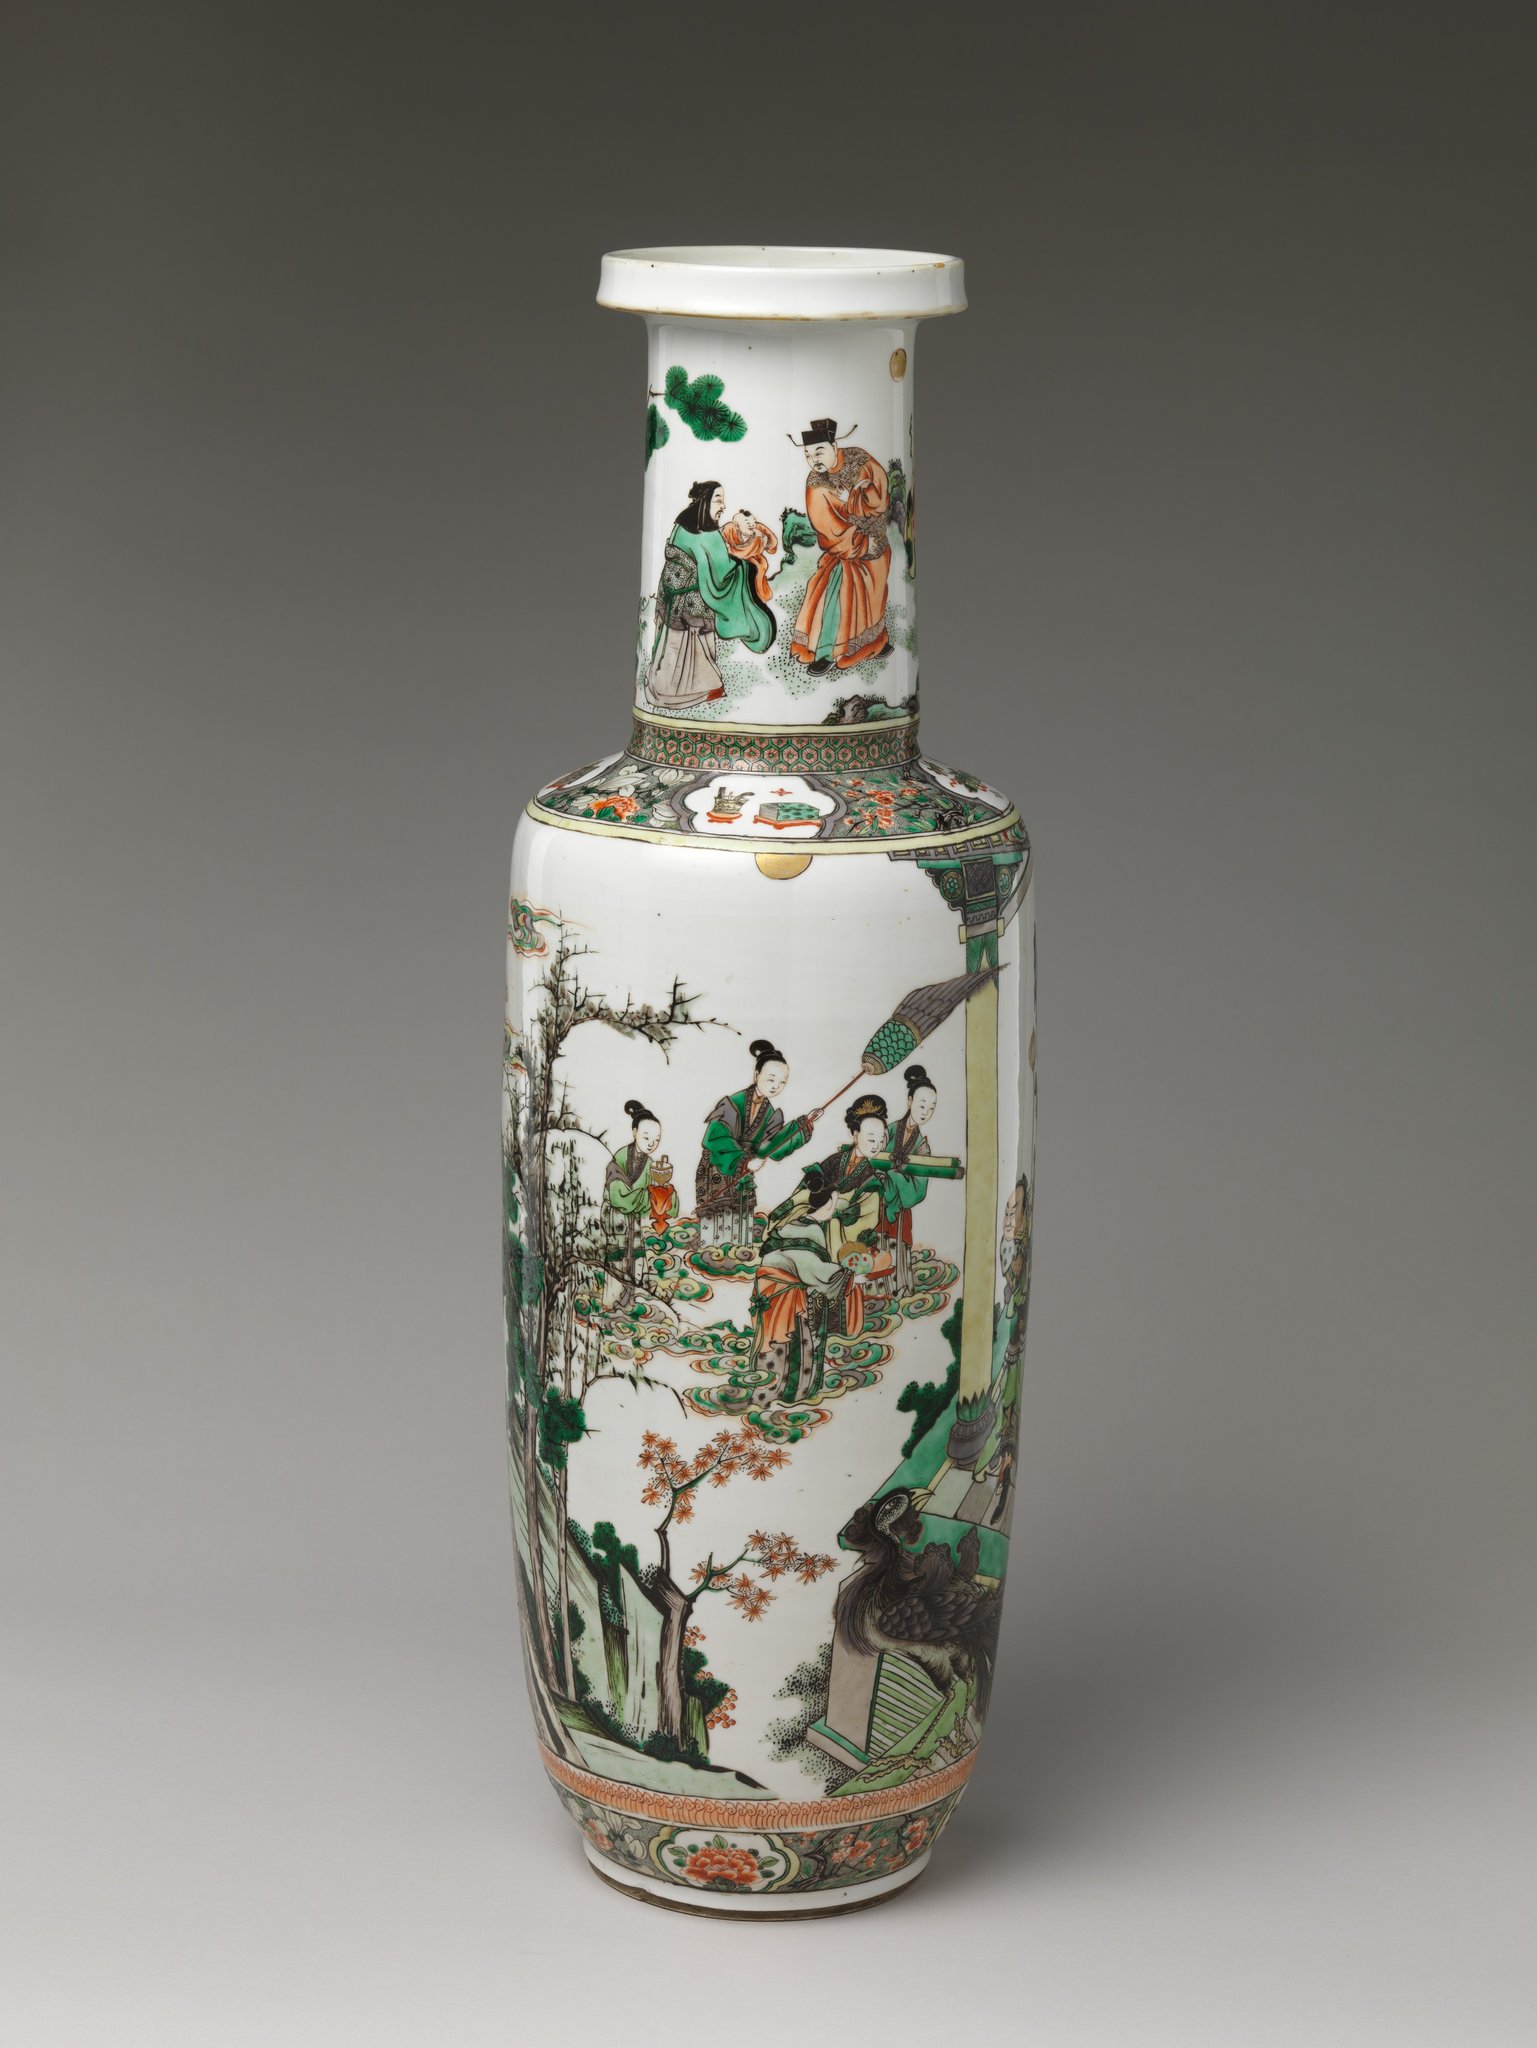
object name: vase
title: Vase with Immortals Offering the Peaches of Longevity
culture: chinese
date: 1662-1722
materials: enamel, porcelain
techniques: overglaze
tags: birds,infants,men,women